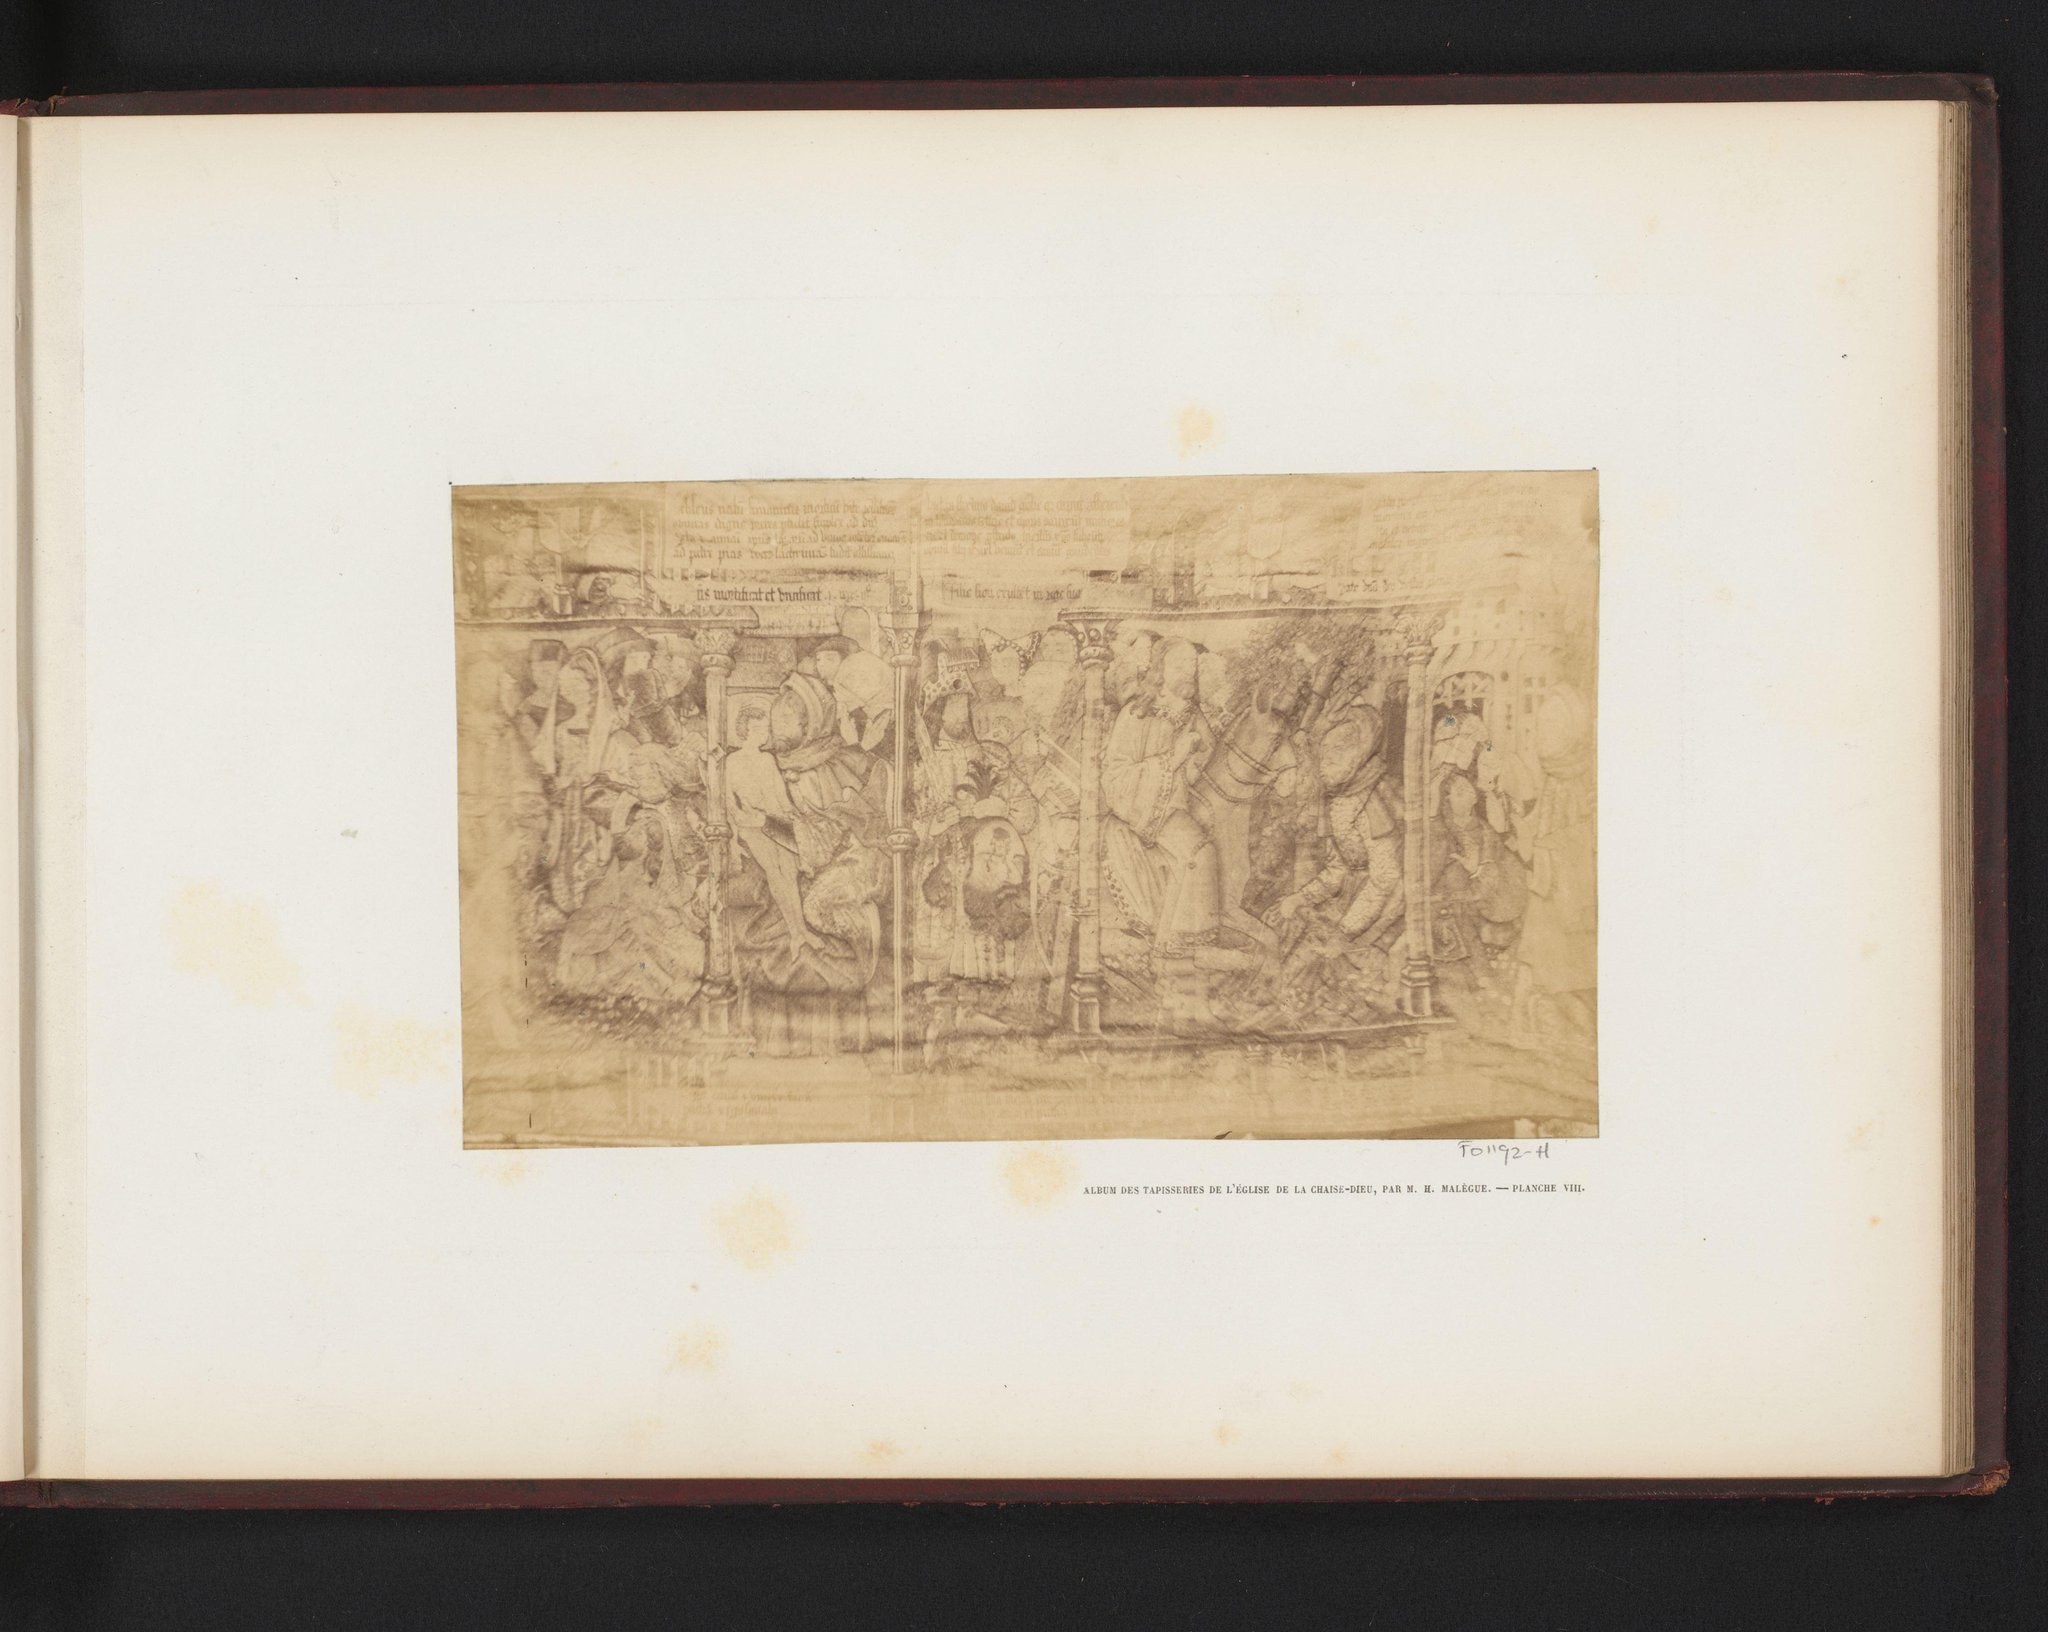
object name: page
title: Tapijt met de intocht in Jeruzalem en prefiguraties in een kerk te La Chaise-Dieu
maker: hippolyte malègue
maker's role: archeoloog, fotograaf, schrijver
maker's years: 1825-1901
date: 1868-1873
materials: photographic support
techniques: albumen print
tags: tapestry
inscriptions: inscription: ‘album des tapisseries de l'église de la Chaise-Dieu, par M. H. Malegue - Planche VIII’